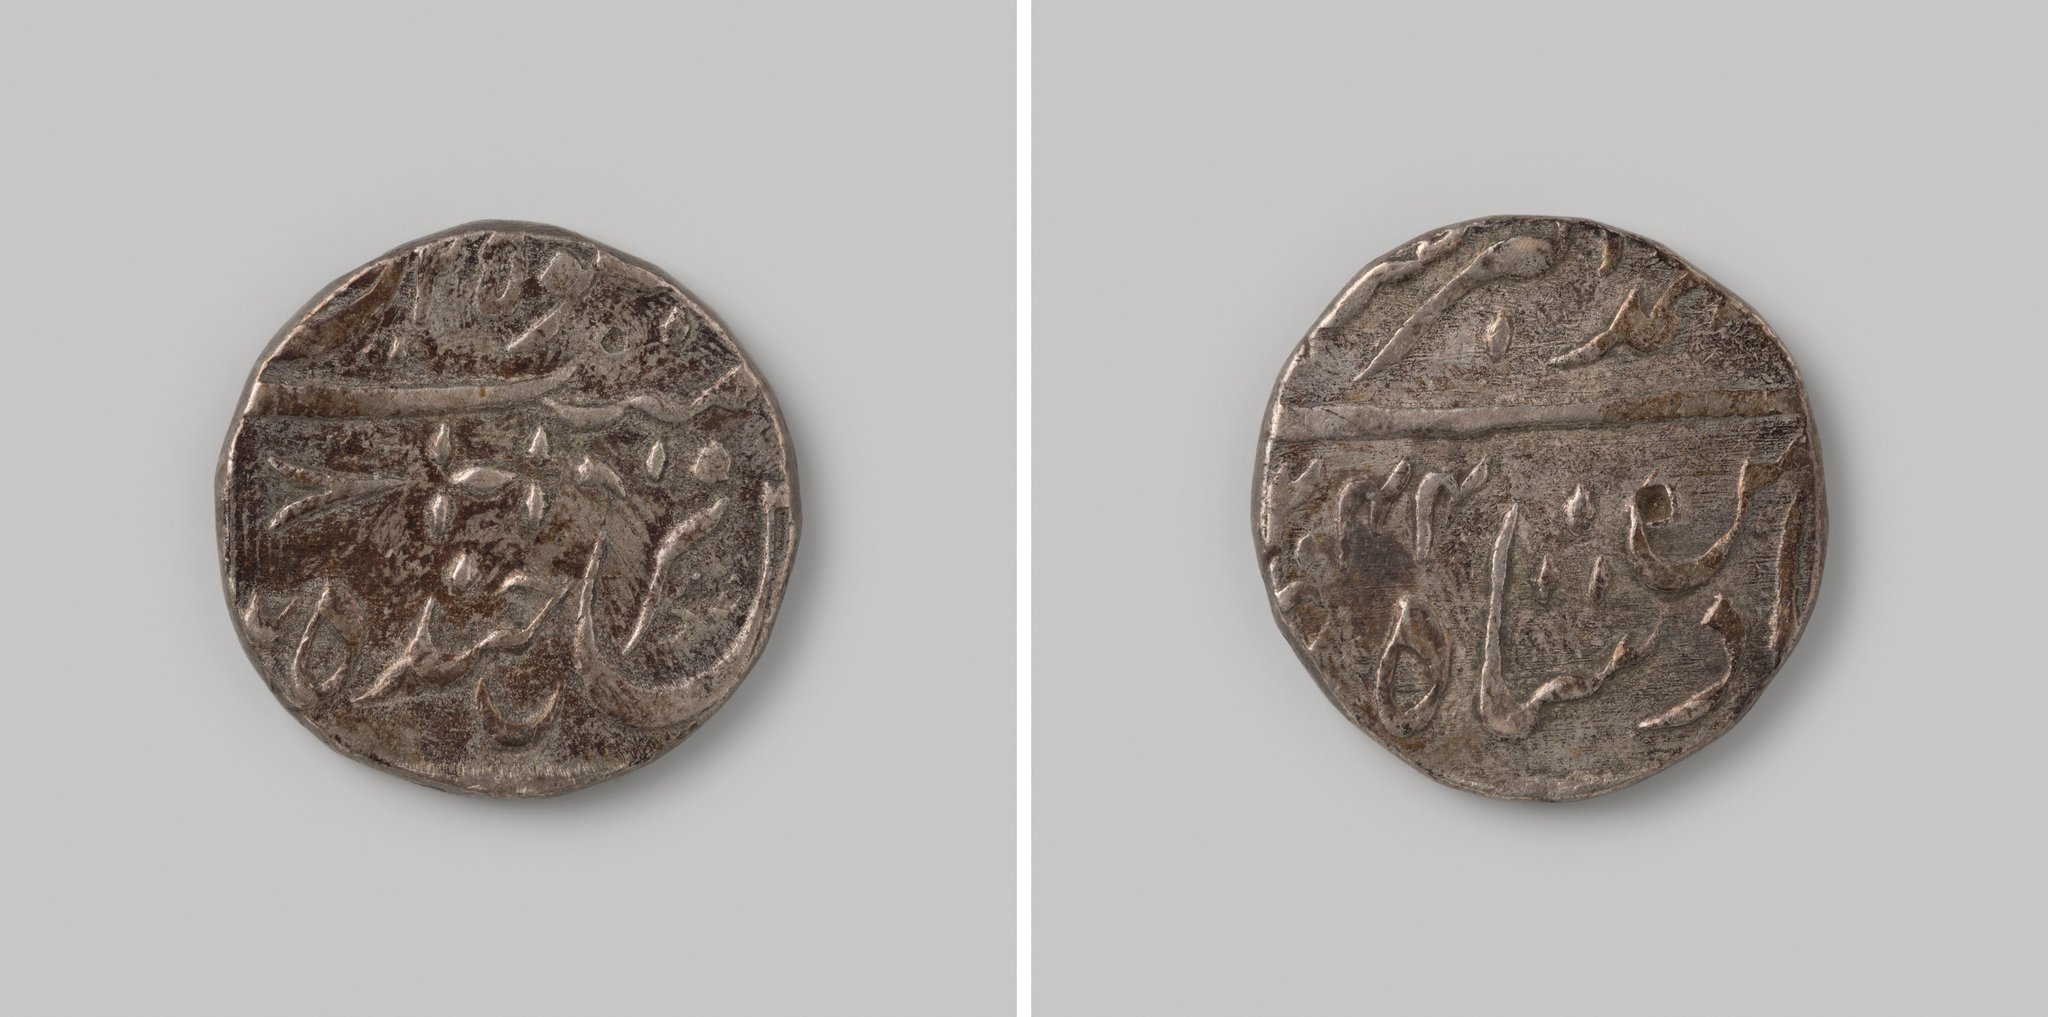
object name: coin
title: Roepie uit India van Mohammed Akbar II, 1244 [=1828], geslagen te Farkhanda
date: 1828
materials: silver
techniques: striking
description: Zilveren munt. Voorzijde: in Arabische lettertekens in drie regels opschrift met naam van de sjah. Keerzijde: in Arabische lettertekens in vier regels opschrift met jaar-aanduiding: 44 en met aanduiding muntplaats: Farkhanda.